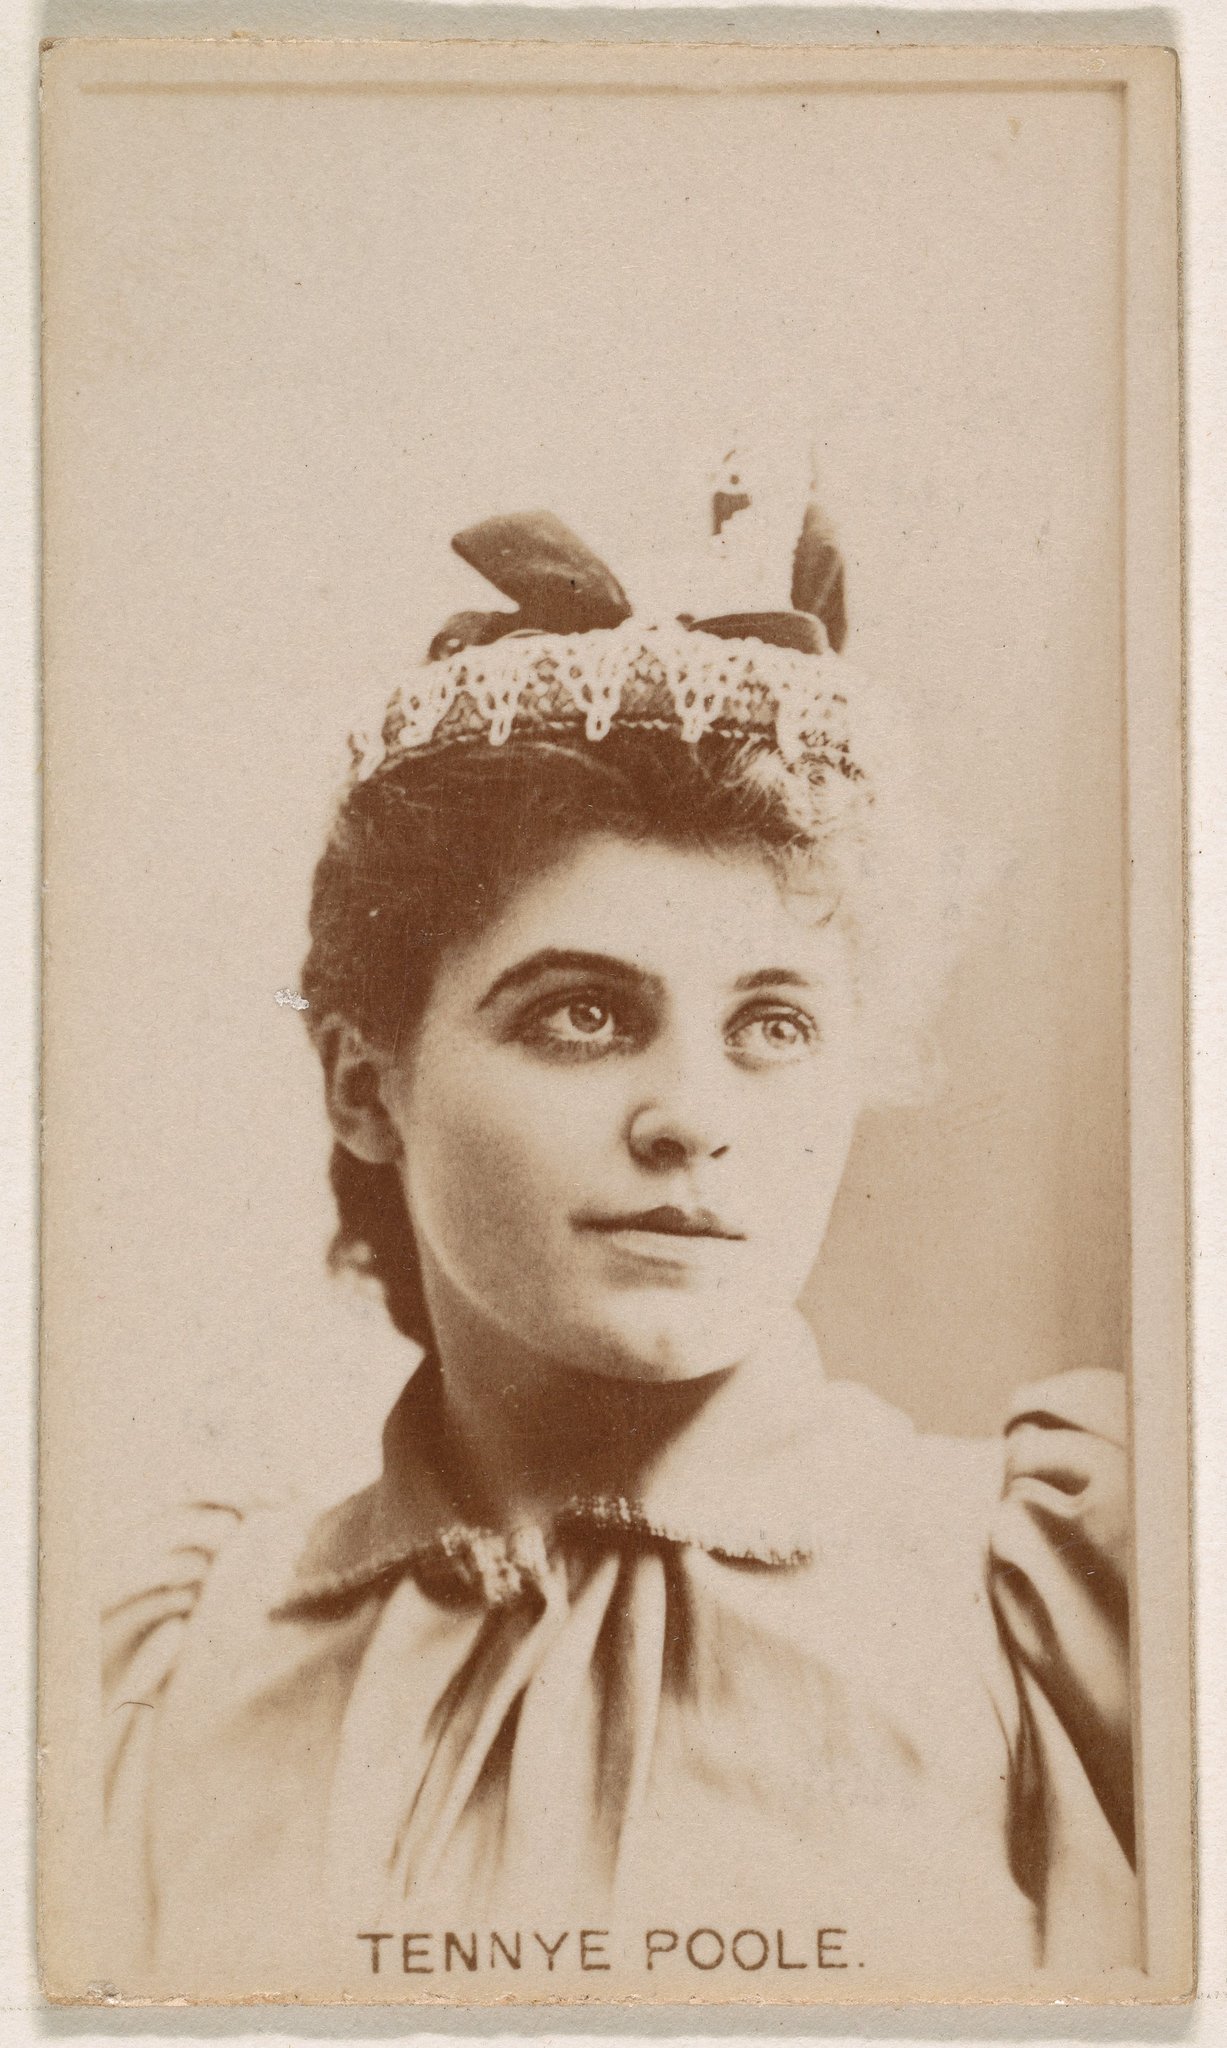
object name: photograph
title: Tennye Poole, from the Actresses series (N245) issued by Kinney Brothers to promote Sweet Caporal Cigarettes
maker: kinney brothers tobacco company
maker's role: publisher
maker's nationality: american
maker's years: 1869-2011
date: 1890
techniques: albumen silver print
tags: portraits,women,actresses